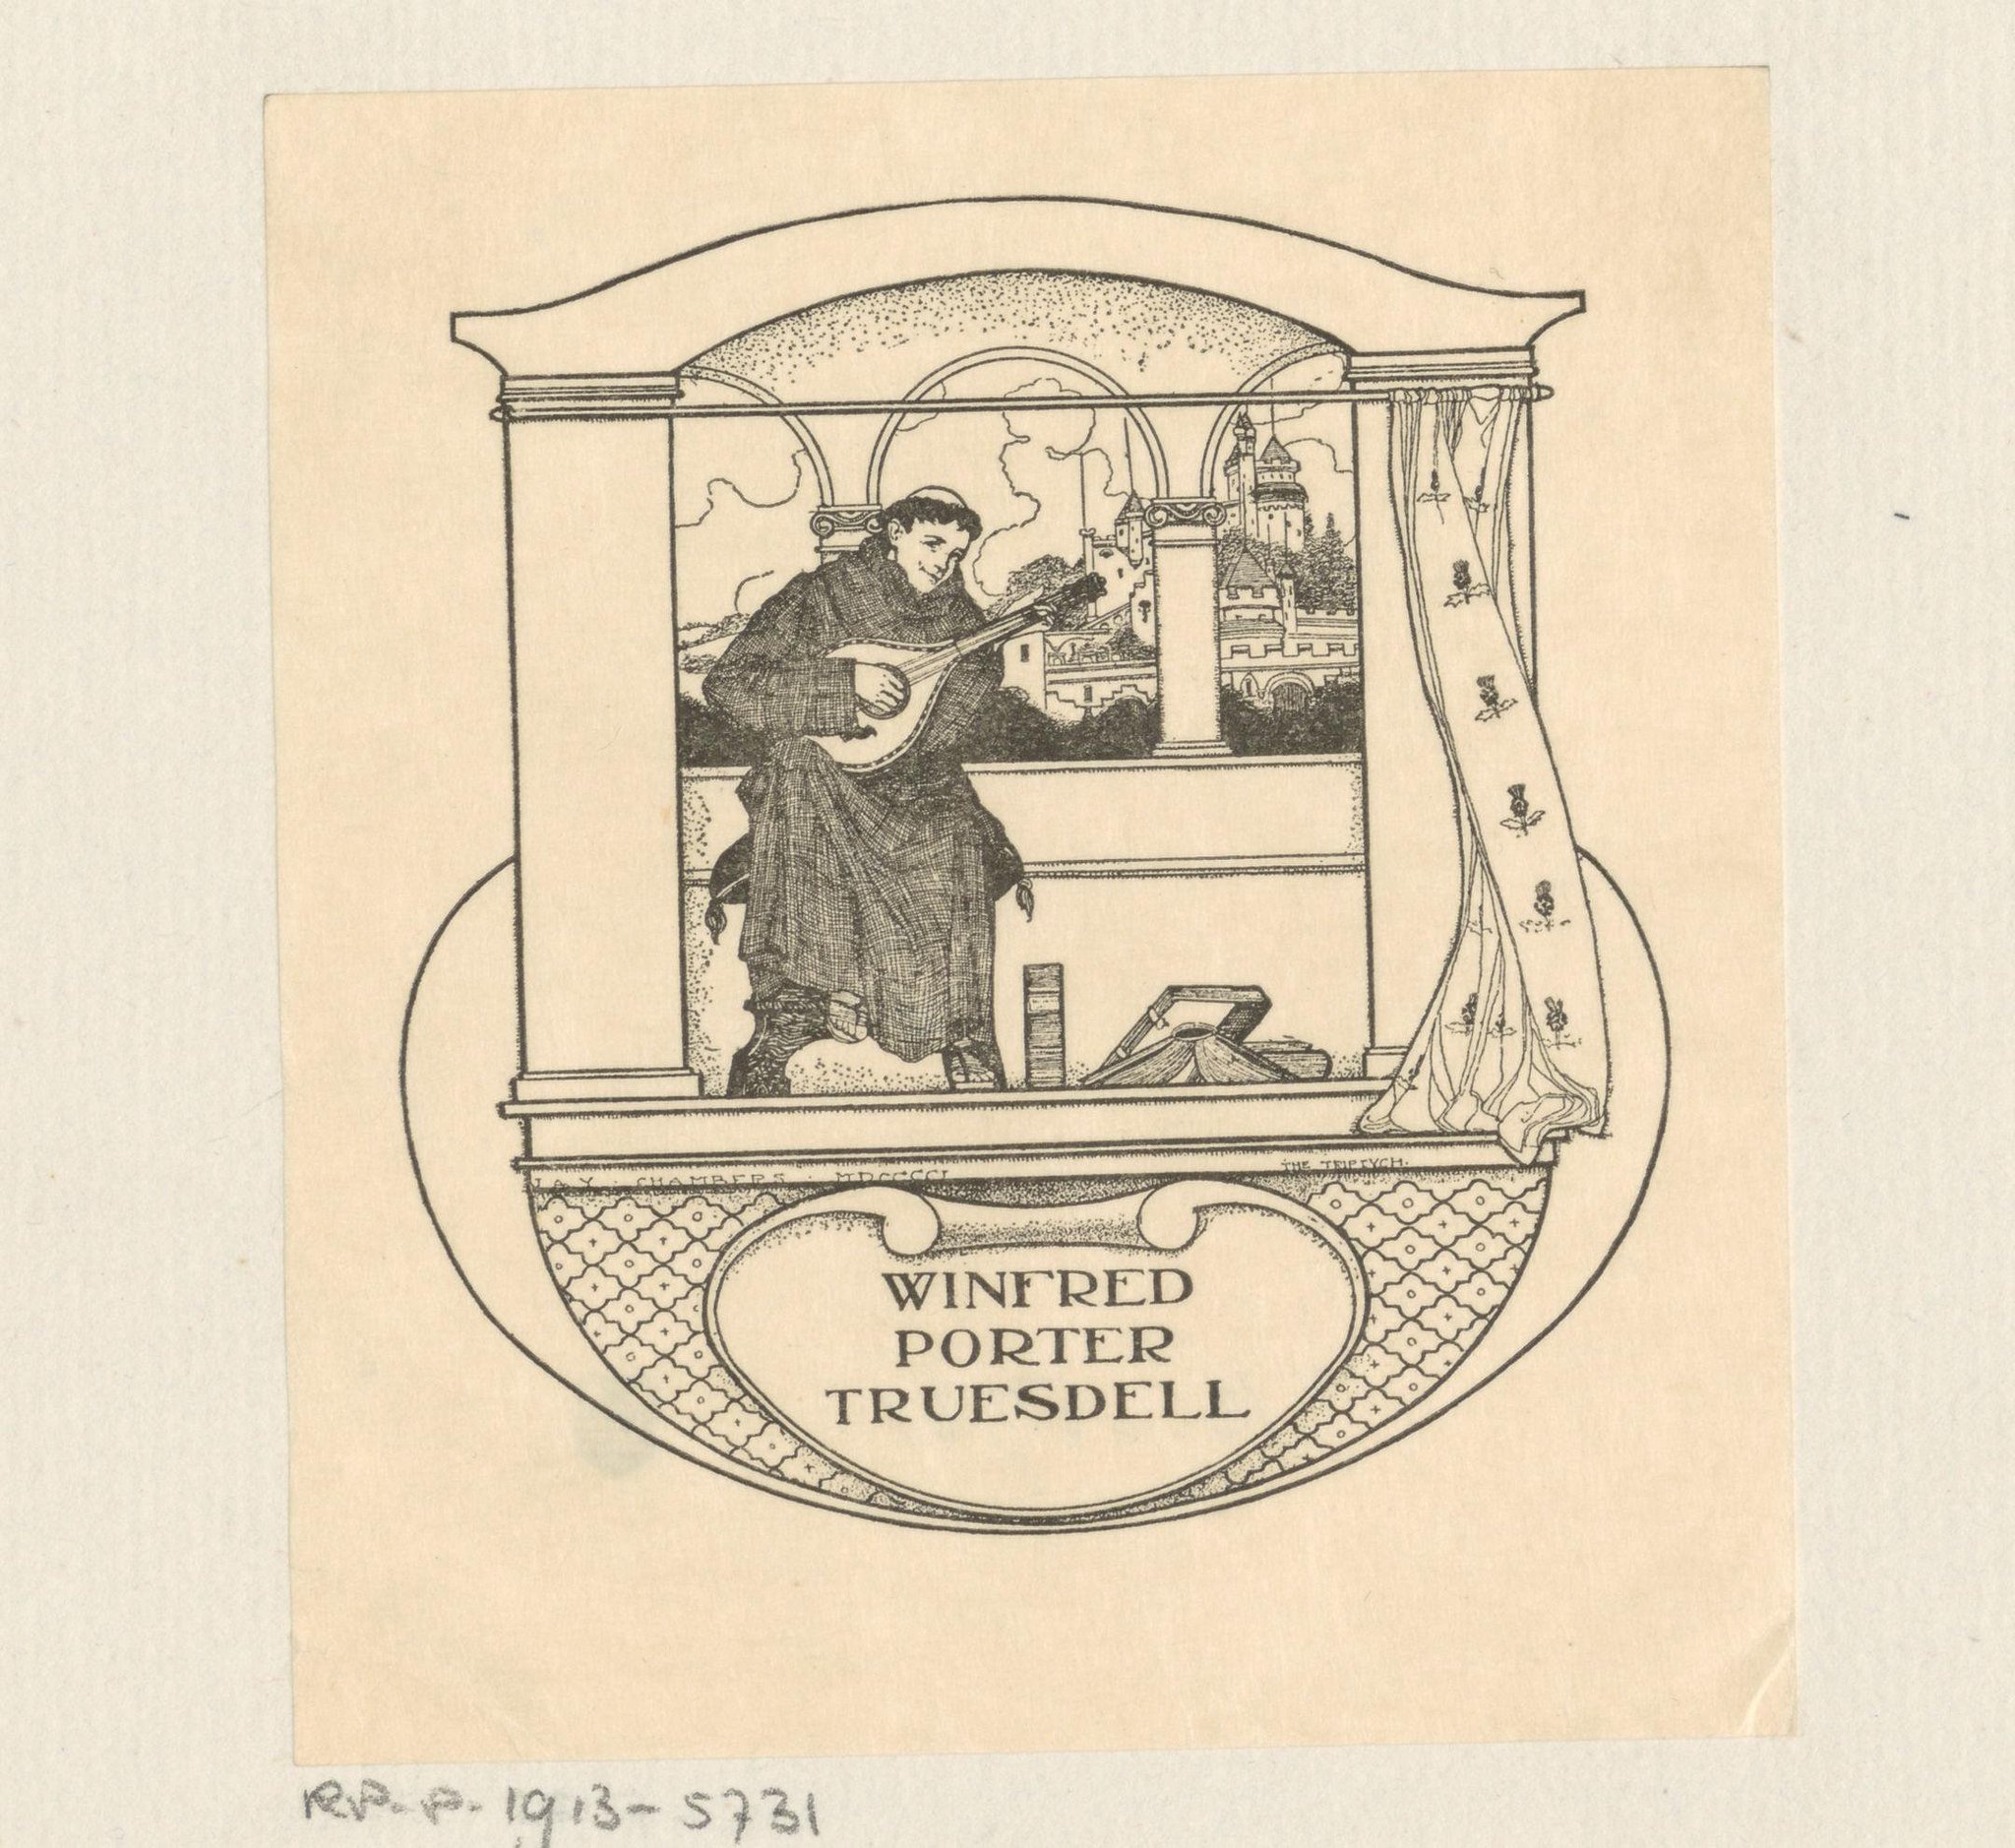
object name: bookplate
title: Ex libris van Winfred Porter Truesdell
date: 1901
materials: paper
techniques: printing block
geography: north and central america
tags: sitting figure, monk(s), friar(s), lute, and special forms of lute, e.g.: theorbo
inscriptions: collector's mark: Lugt 2760, collector's mark: Lugt 2233